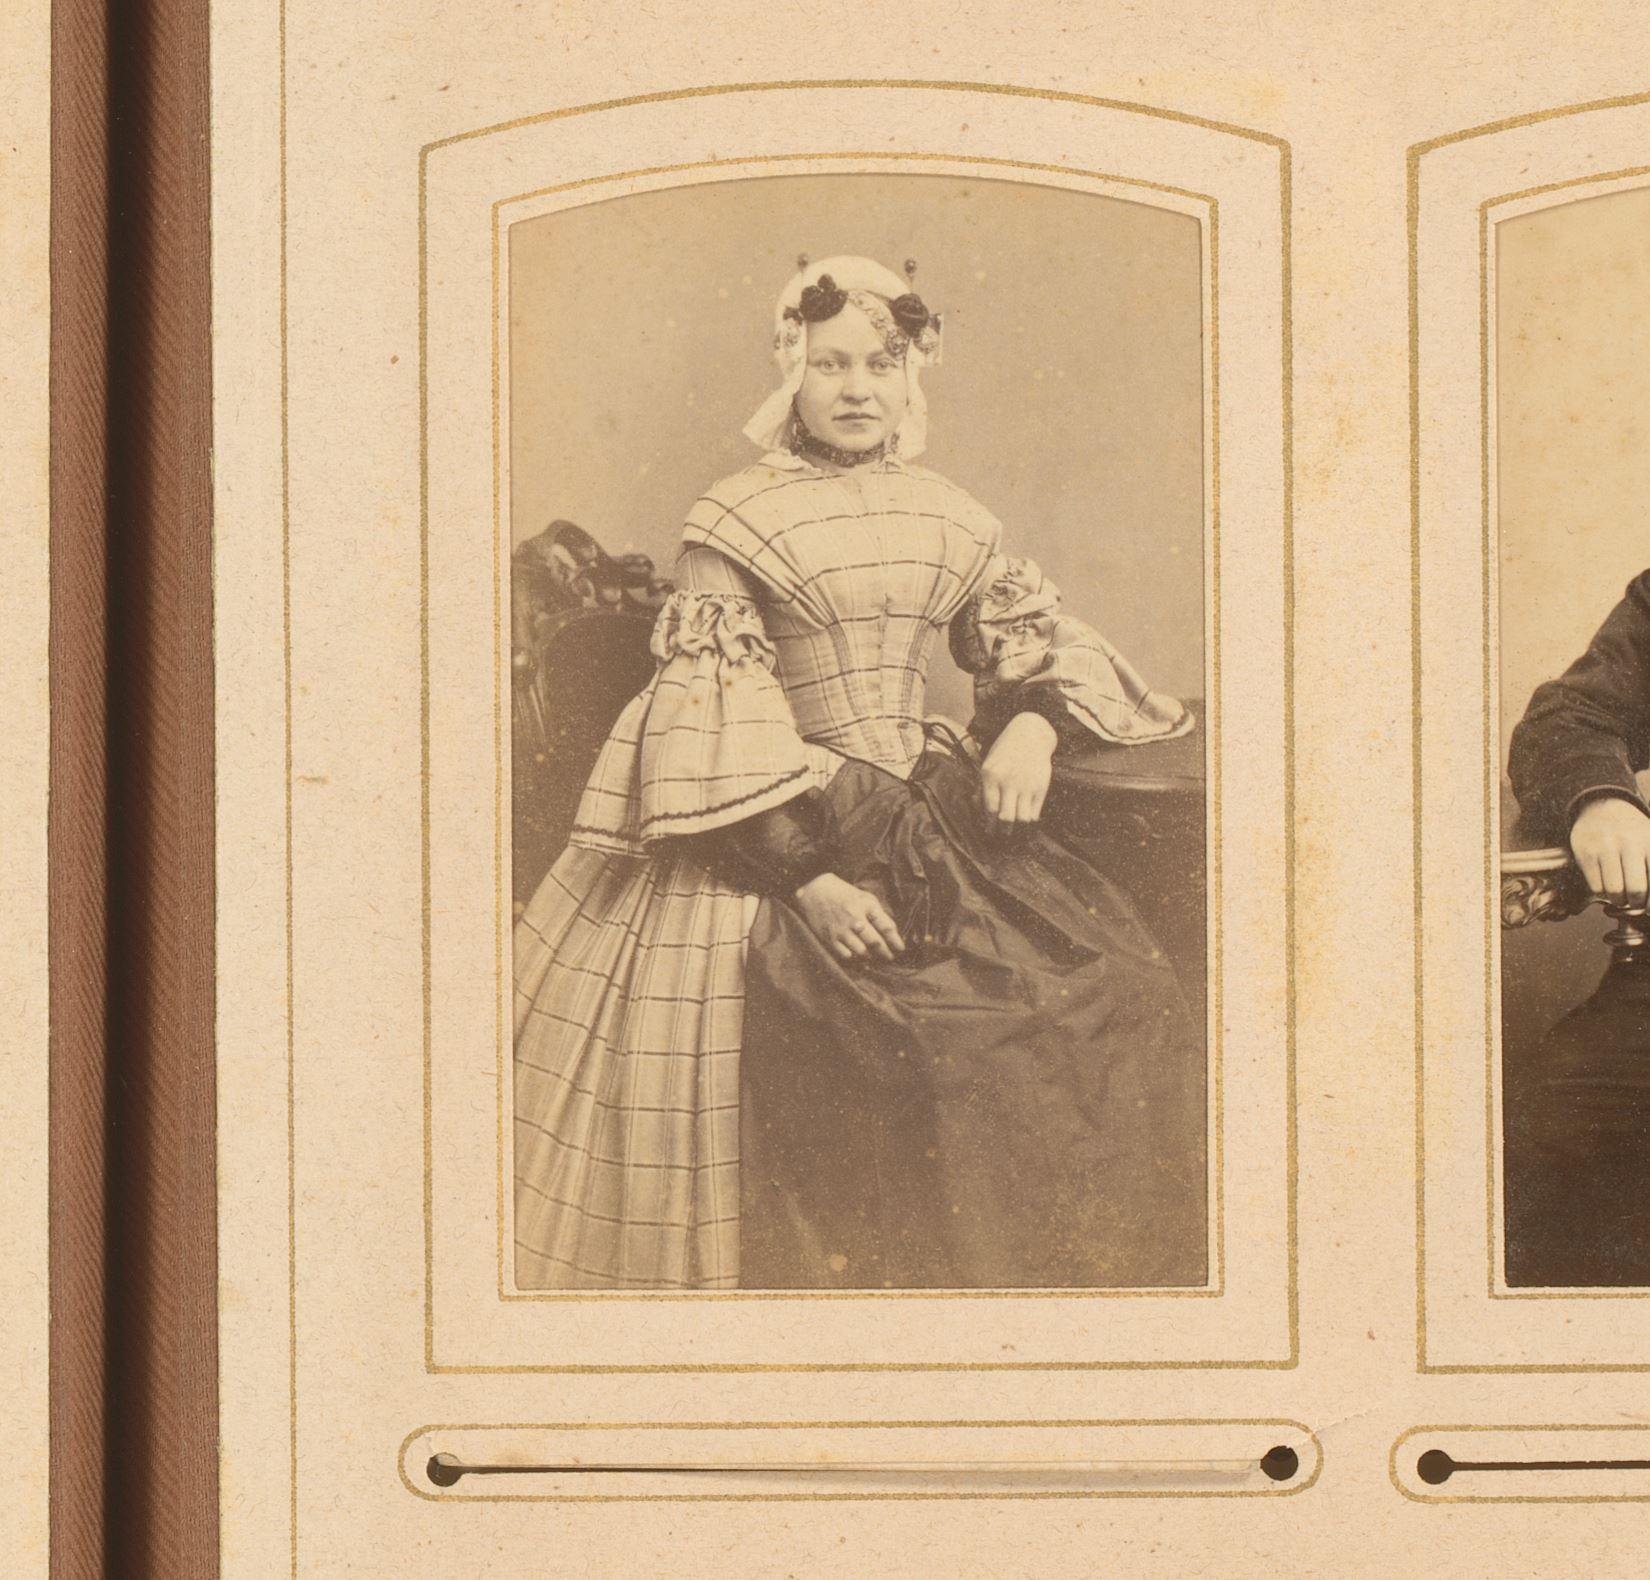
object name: album leaf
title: Portret van een vrouw met klederdrachtmuts, zittend aan een tafel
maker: pieter siewers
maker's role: fotograaf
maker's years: 1819-1898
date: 1857-1898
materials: cardboard, photographic support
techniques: albumen print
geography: edam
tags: sitting figure - aa - female human figure, historical persons - bb - woman, table, head-gear: cap, folk costume, regional costume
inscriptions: inscription: ‘P. SIEWERS/ PHOTOGRAAF/ EDAM’